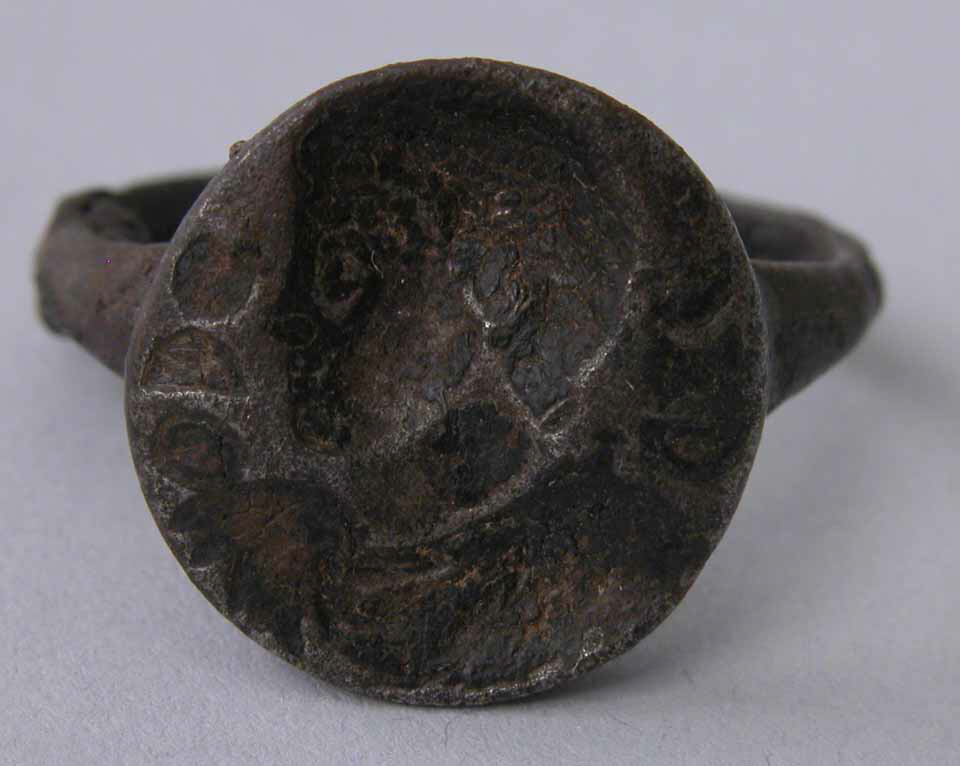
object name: ring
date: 201-1200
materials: iron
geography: egypt